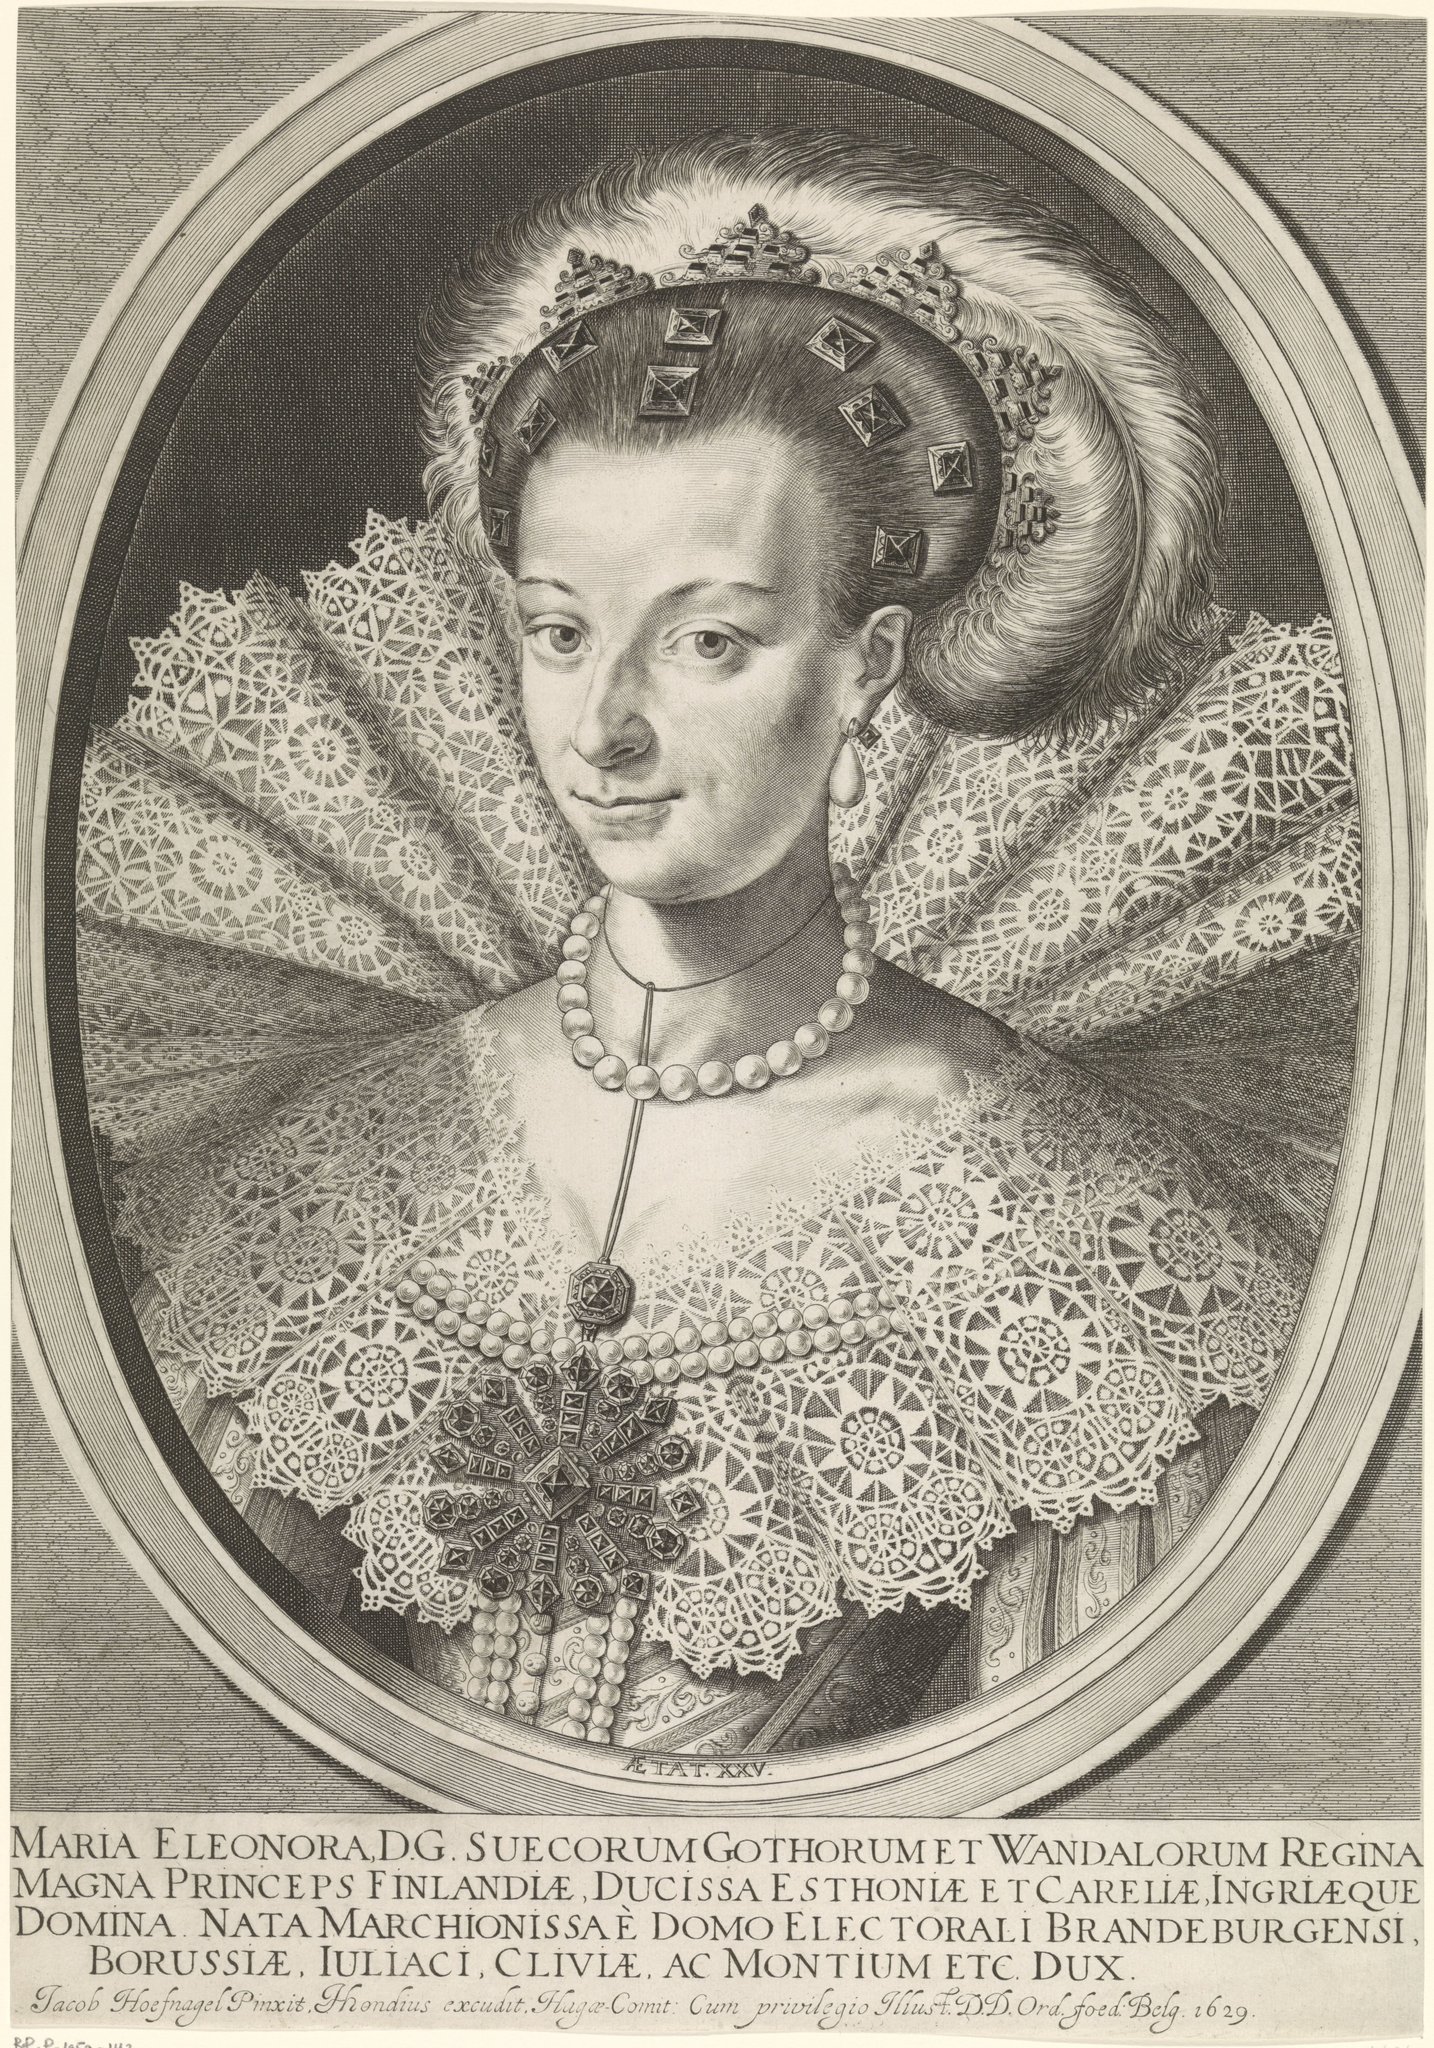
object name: print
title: Portret van Maria Eleonora, Koningin van Zweden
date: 1629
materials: paper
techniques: engraving, etching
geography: the hague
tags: ear-rings (+ women's clothes), pendant, trinket, 'breloque' (+ women's clothes), brooch, agraffe, clasp (+ women's clothes), neck-gear: collar (+ lace used for clothes), pearl; pearl necklace (+ women's clothes)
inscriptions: collector's mark: Lugt 2228, collector's mark: Lugt 2760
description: Buste naar links van Maria Eleonora, Koningin van Zweden op 25-jarige leeftijd in een ovale omlijsting. Onder het portret twee regels in het Latijn.